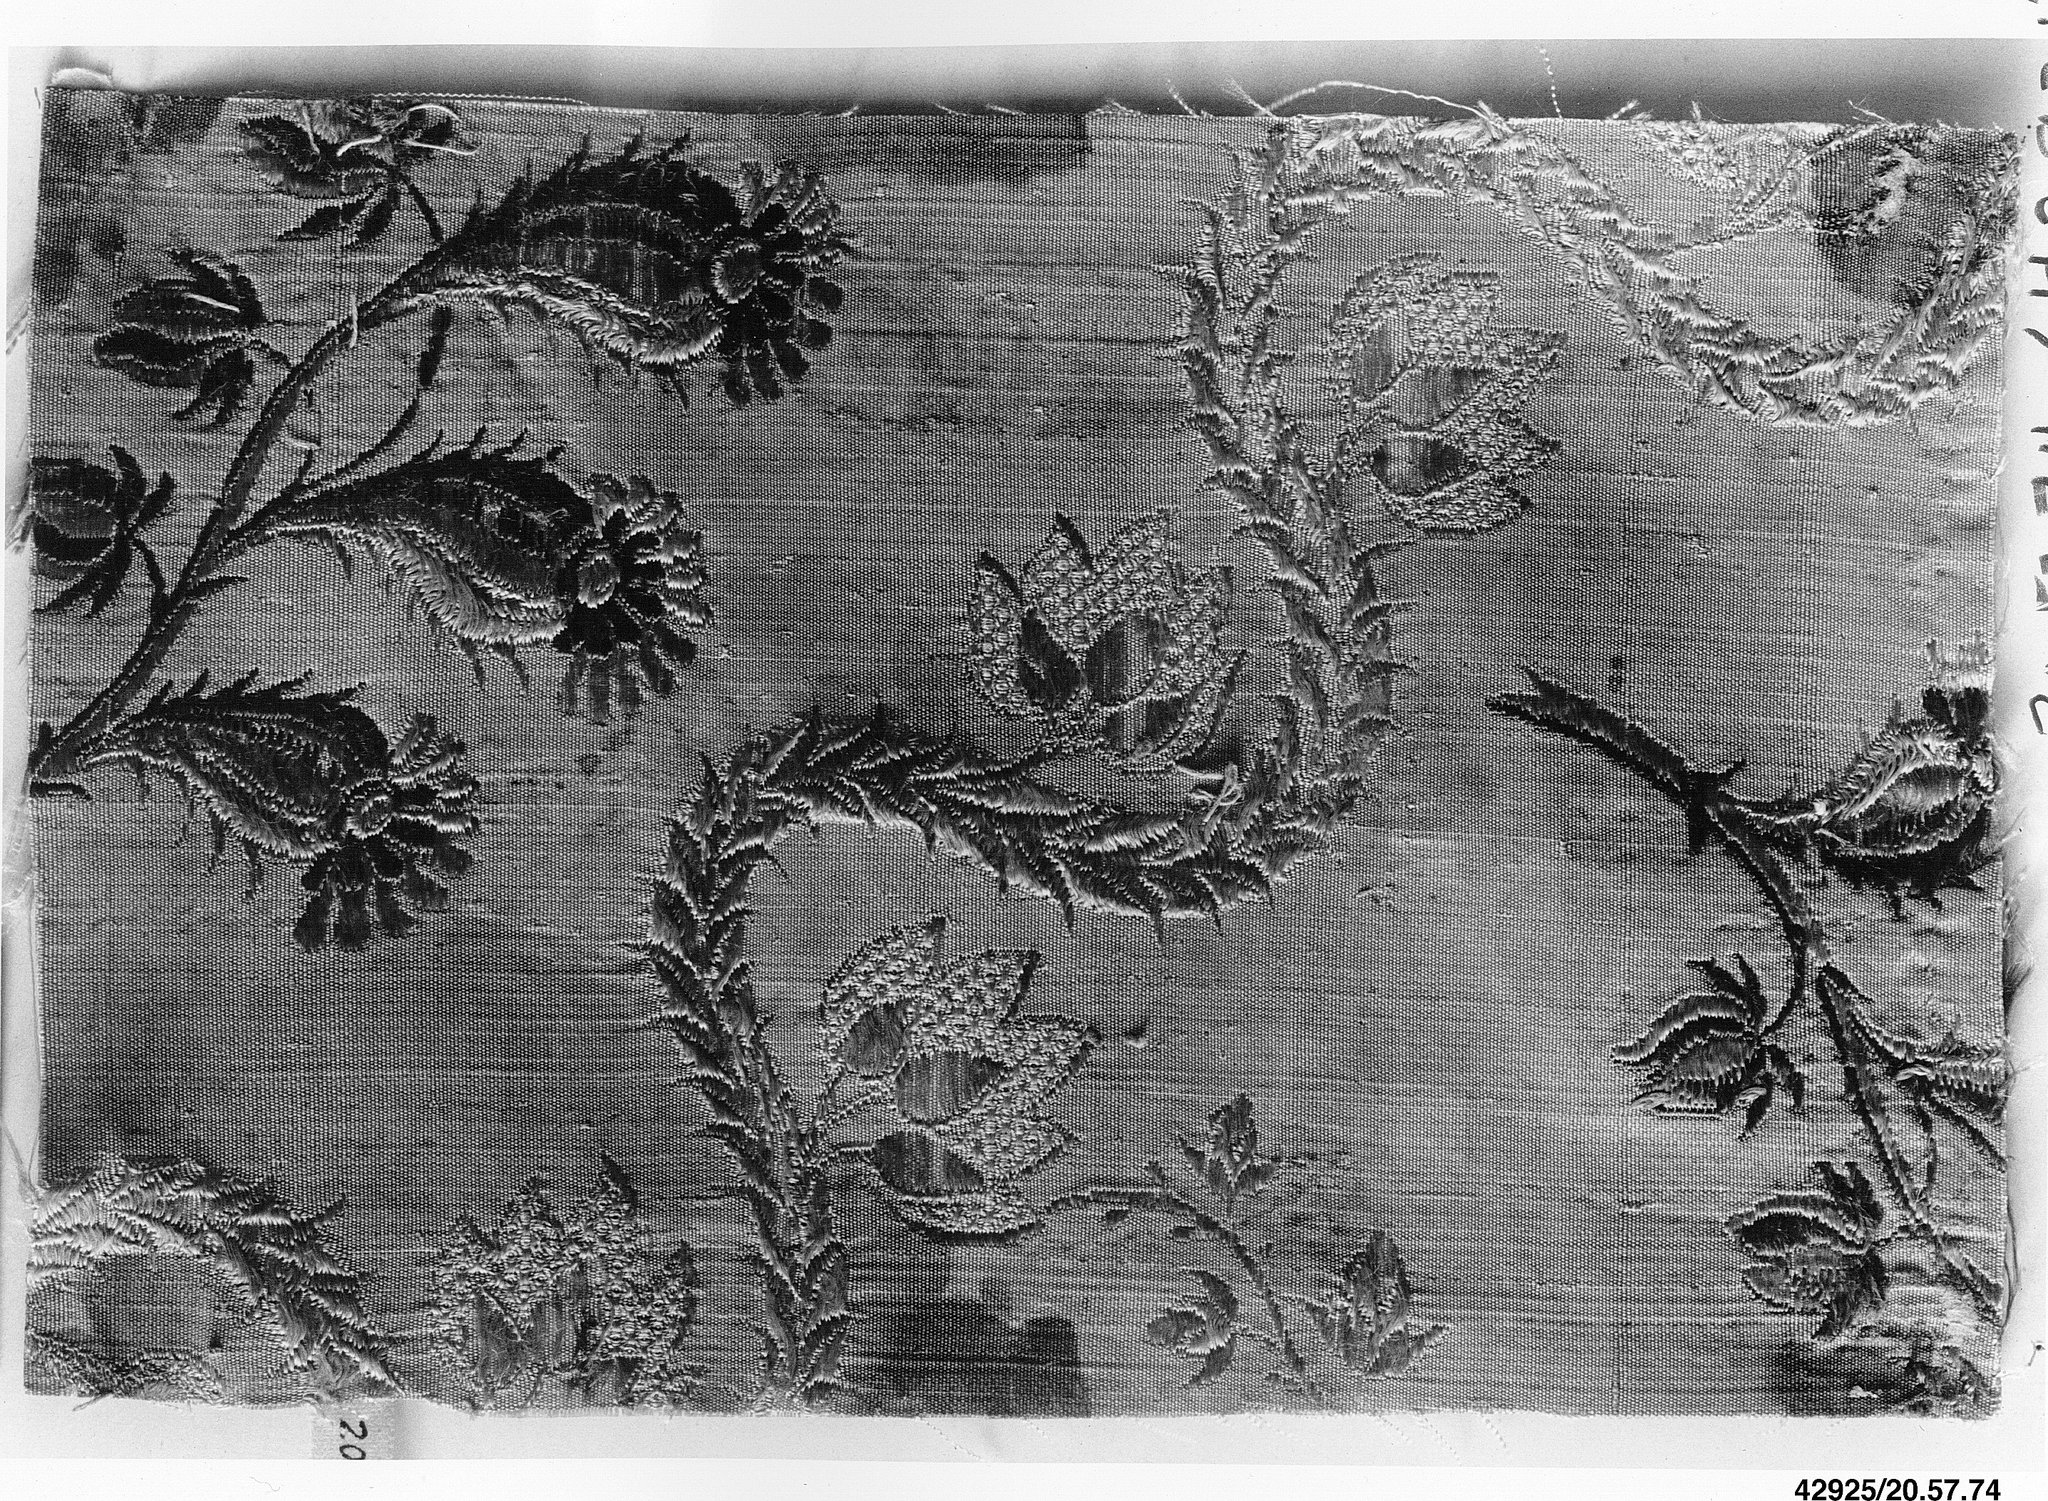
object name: piece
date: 1750-1760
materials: silk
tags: flowers,leaves